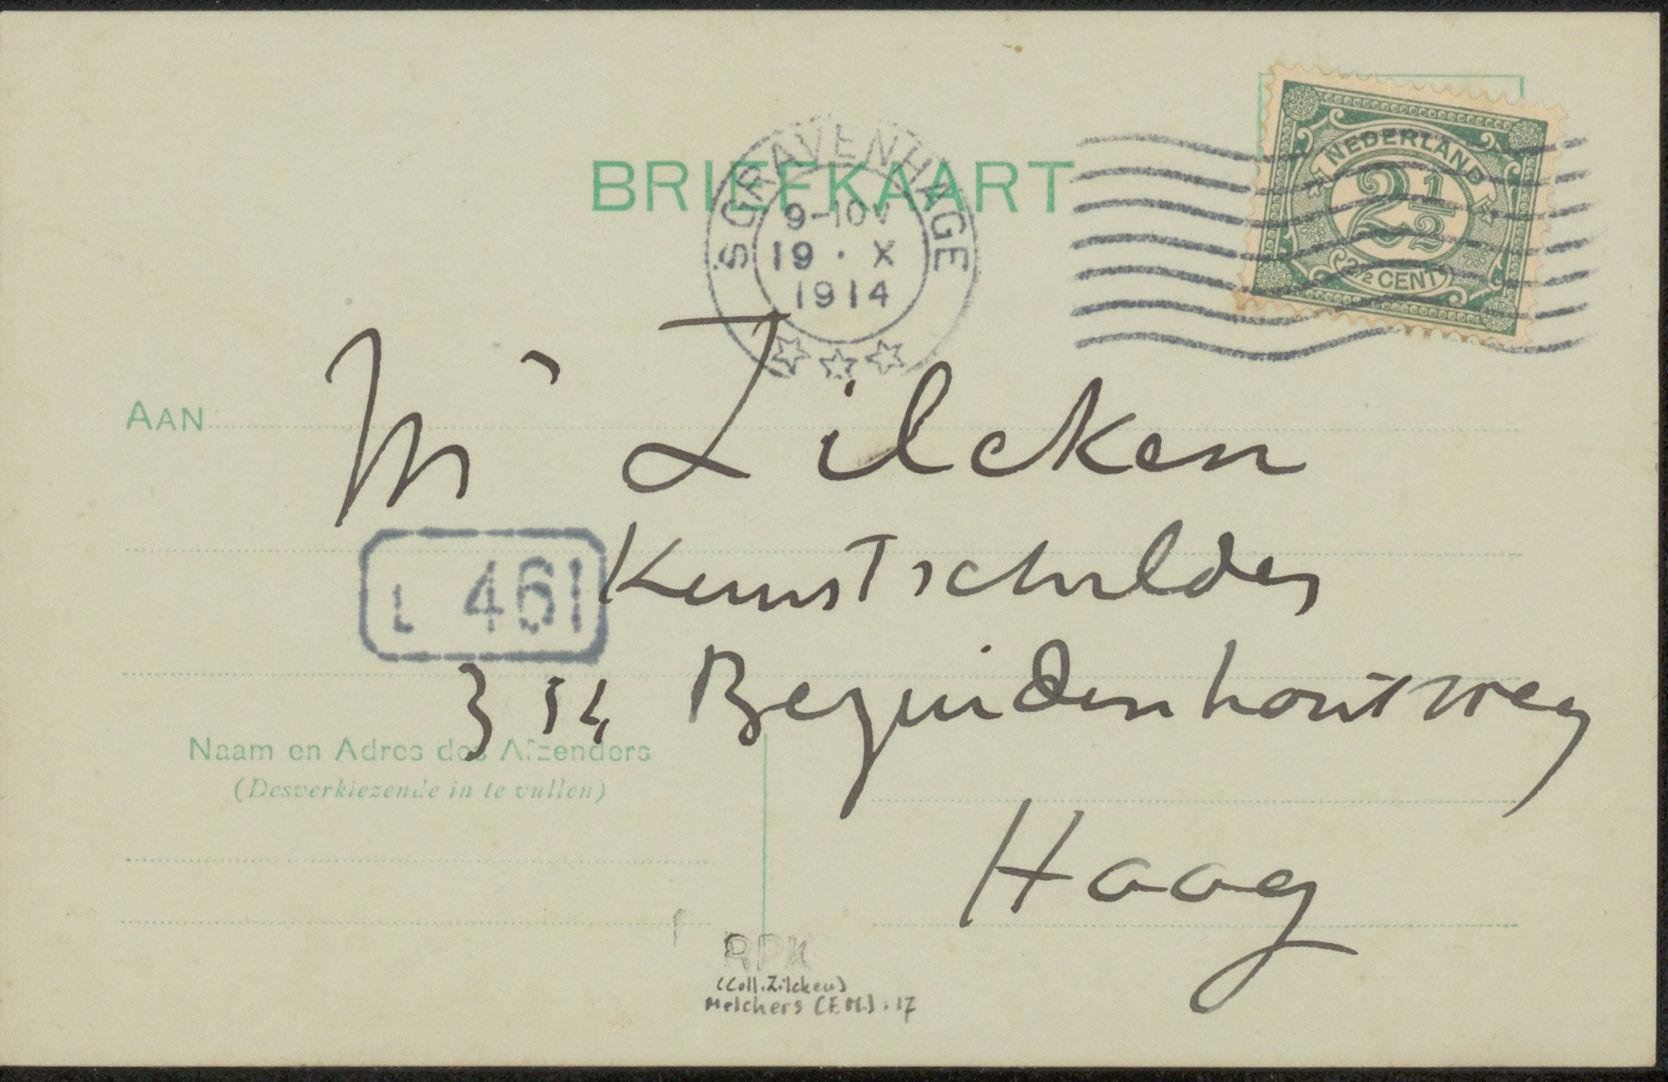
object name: postcard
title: Briefkaart aan Philip Zilcken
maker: franz melchers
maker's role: draughtsman, painter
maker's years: 1868-1944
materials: cardboard, ink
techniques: pen, writing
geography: the hague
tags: the hague, philip zilcken, the graphic arts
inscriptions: collector's mark: ‘RPK’